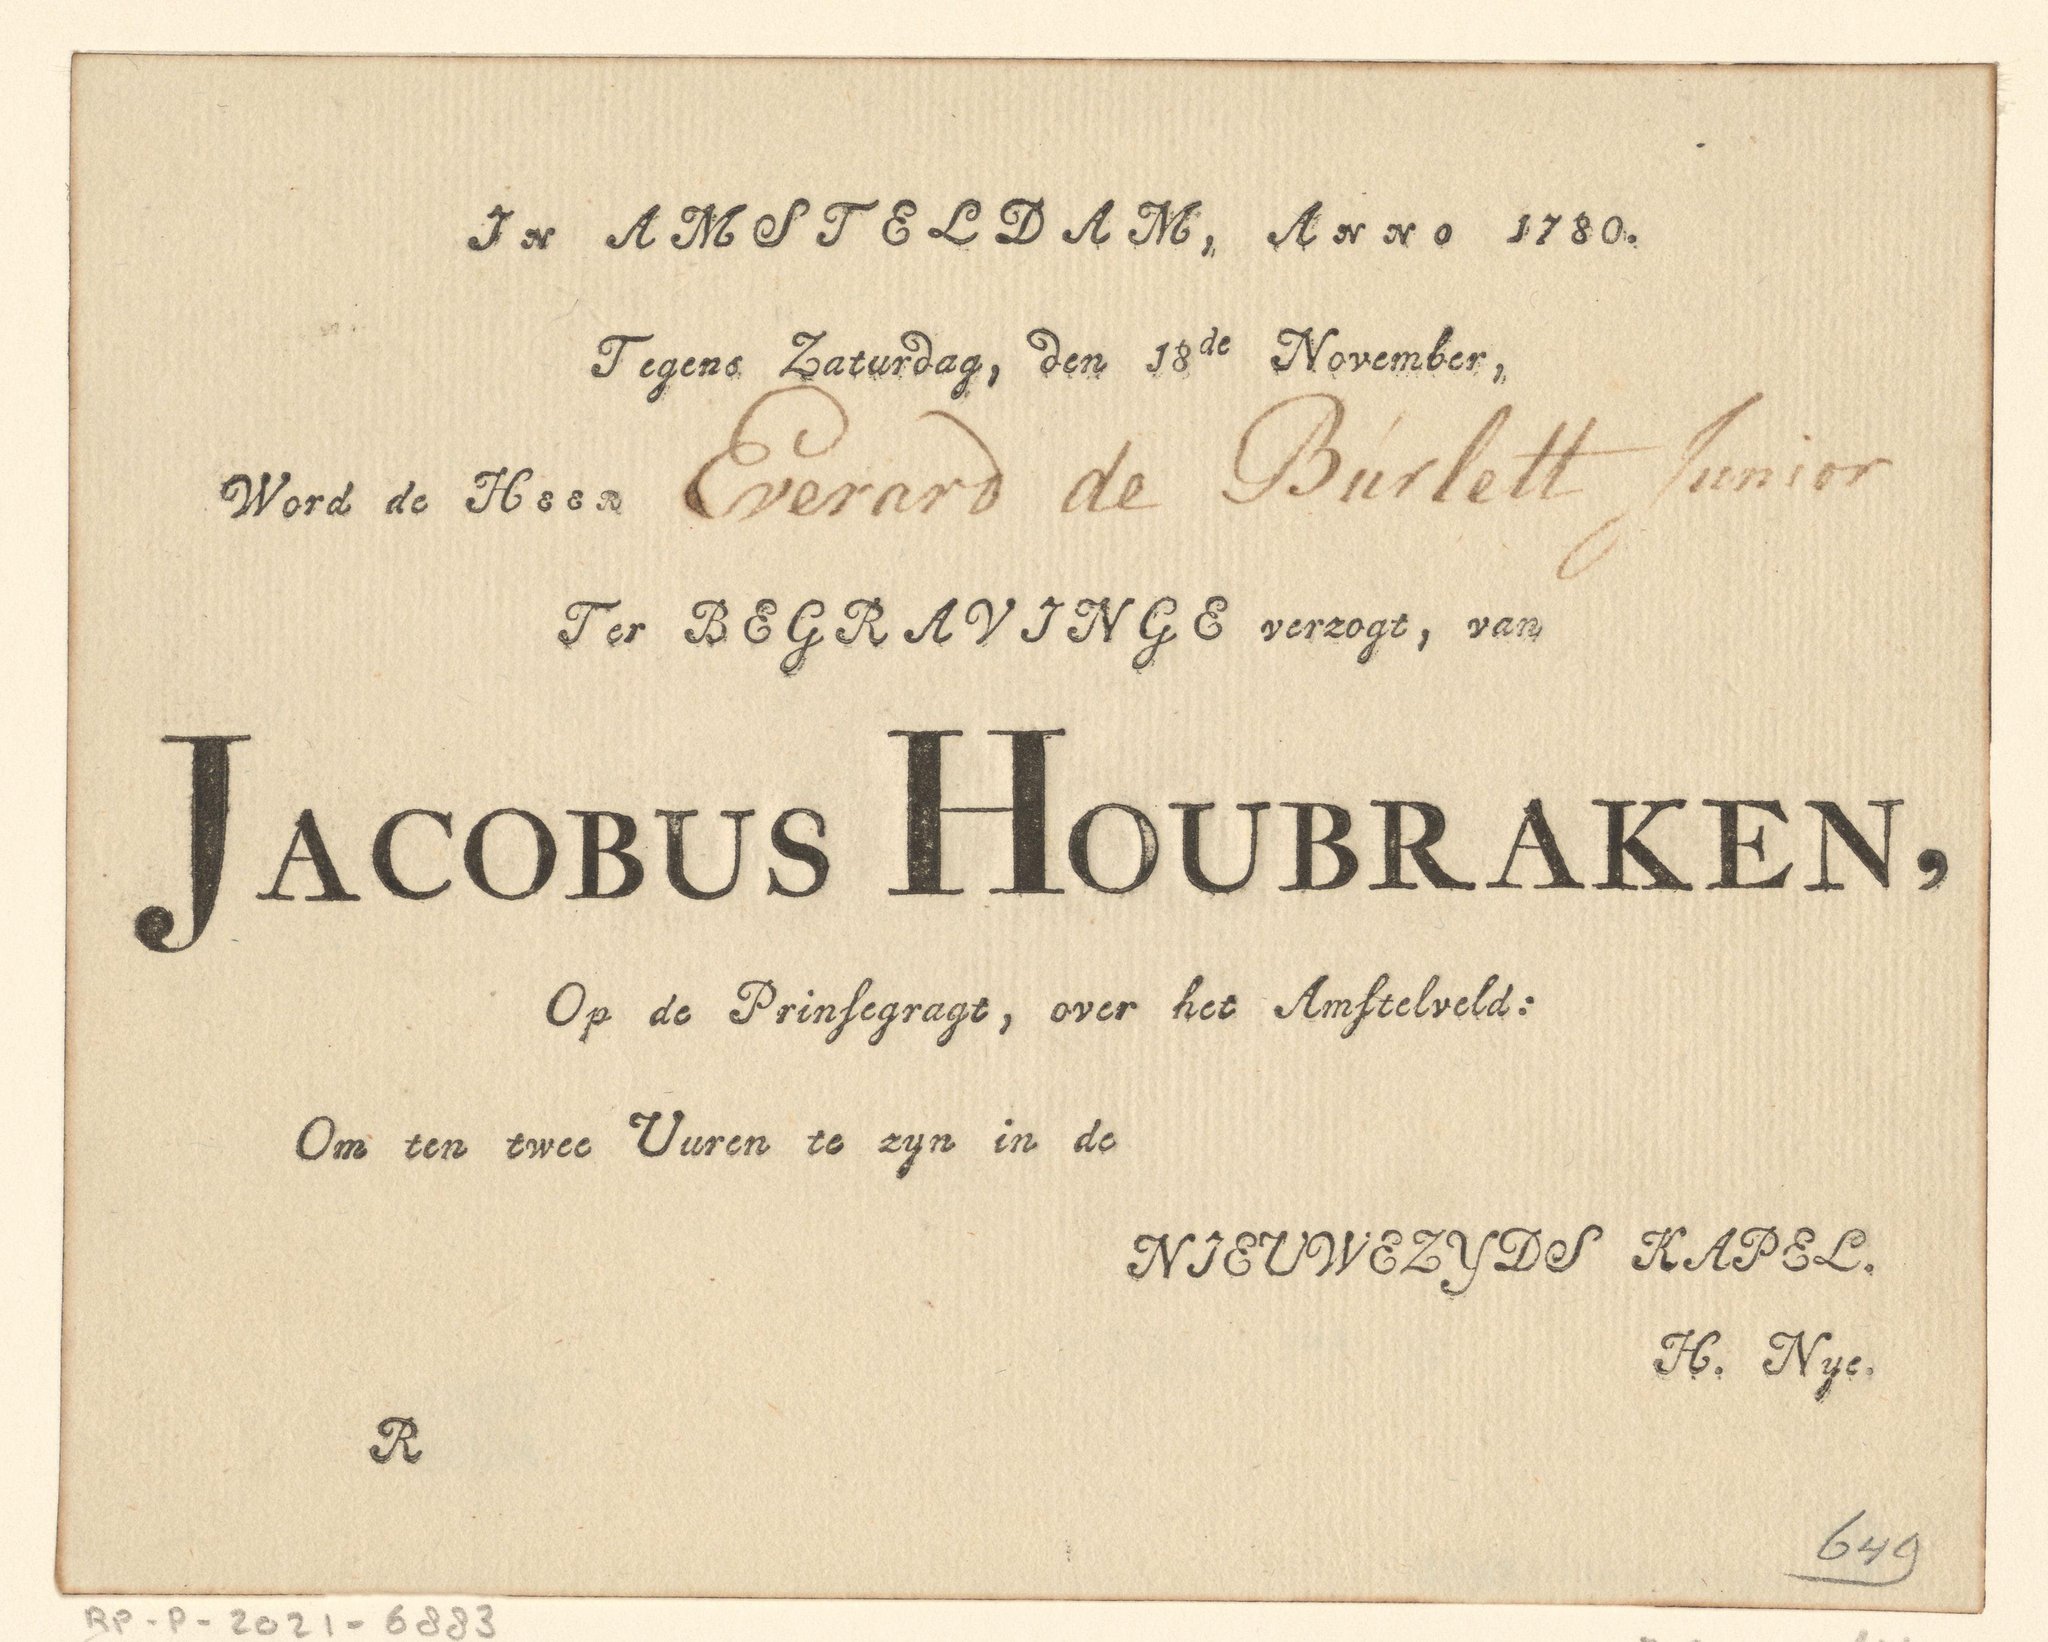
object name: text sheet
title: Uitnodiging voor de begrafenis van Jacob Houbraken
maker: Anonymous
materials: paper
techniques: letterpress printing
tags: amsterdam, jacob houbraken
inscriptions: inscription: ‘Everard de Burlett Junior’, collector's mark: Lugt 2166, collector's mark: Lugt 2760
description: Geadresseerd aan Everard de Burlett (1731-1806).